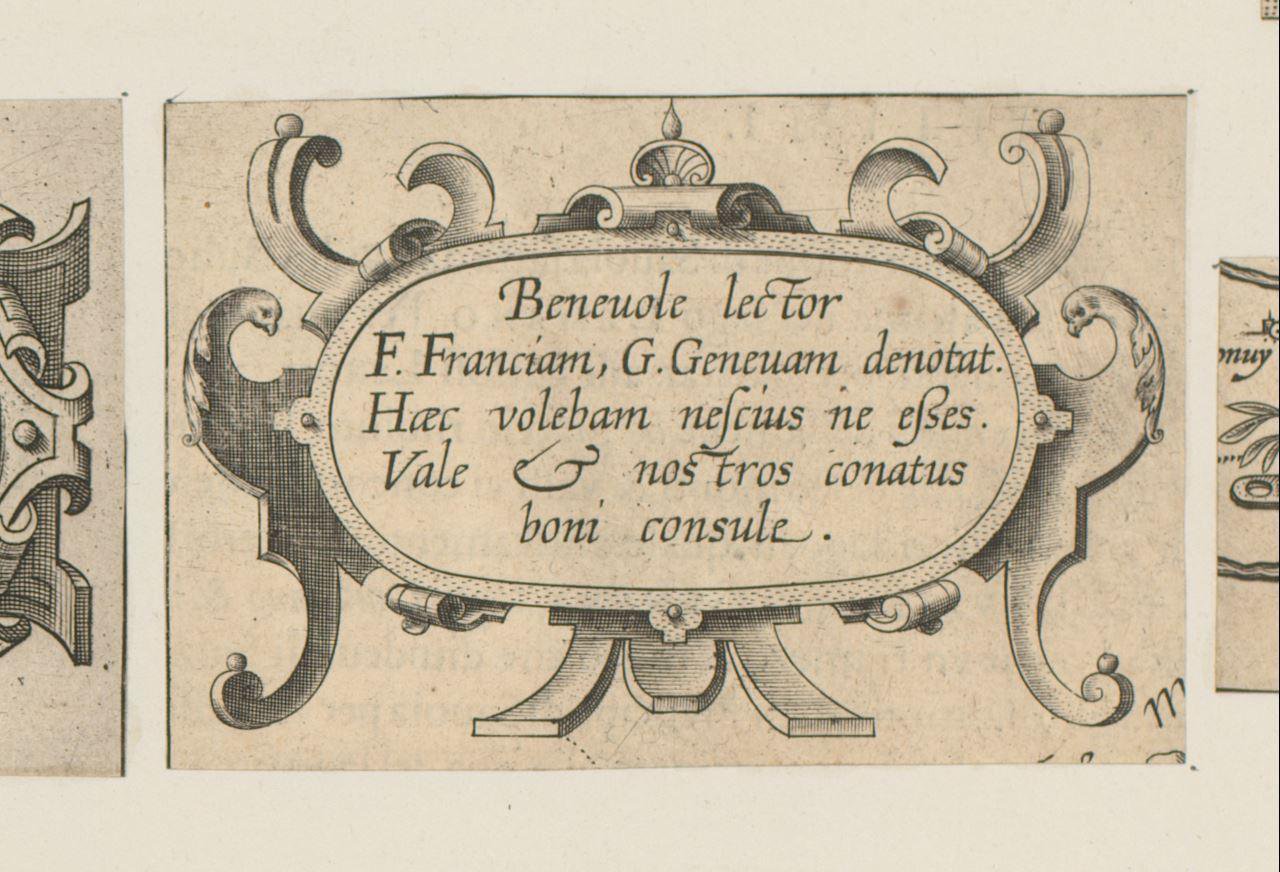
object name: ornament print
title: Cartouche van een kaart van het meer van Genève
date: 1607-1608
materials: paper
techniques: engraving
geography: antwerp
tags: scrollwork, strapwork ~ ornament, ornament ~ cartouche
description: Ovale cartouche met rolwerk. Links en rechts loop het rolwerk door in een vogelkop. De cartouche is een fragment van een kaart van het meer van Genève. De prent maakt deel uit van een album.